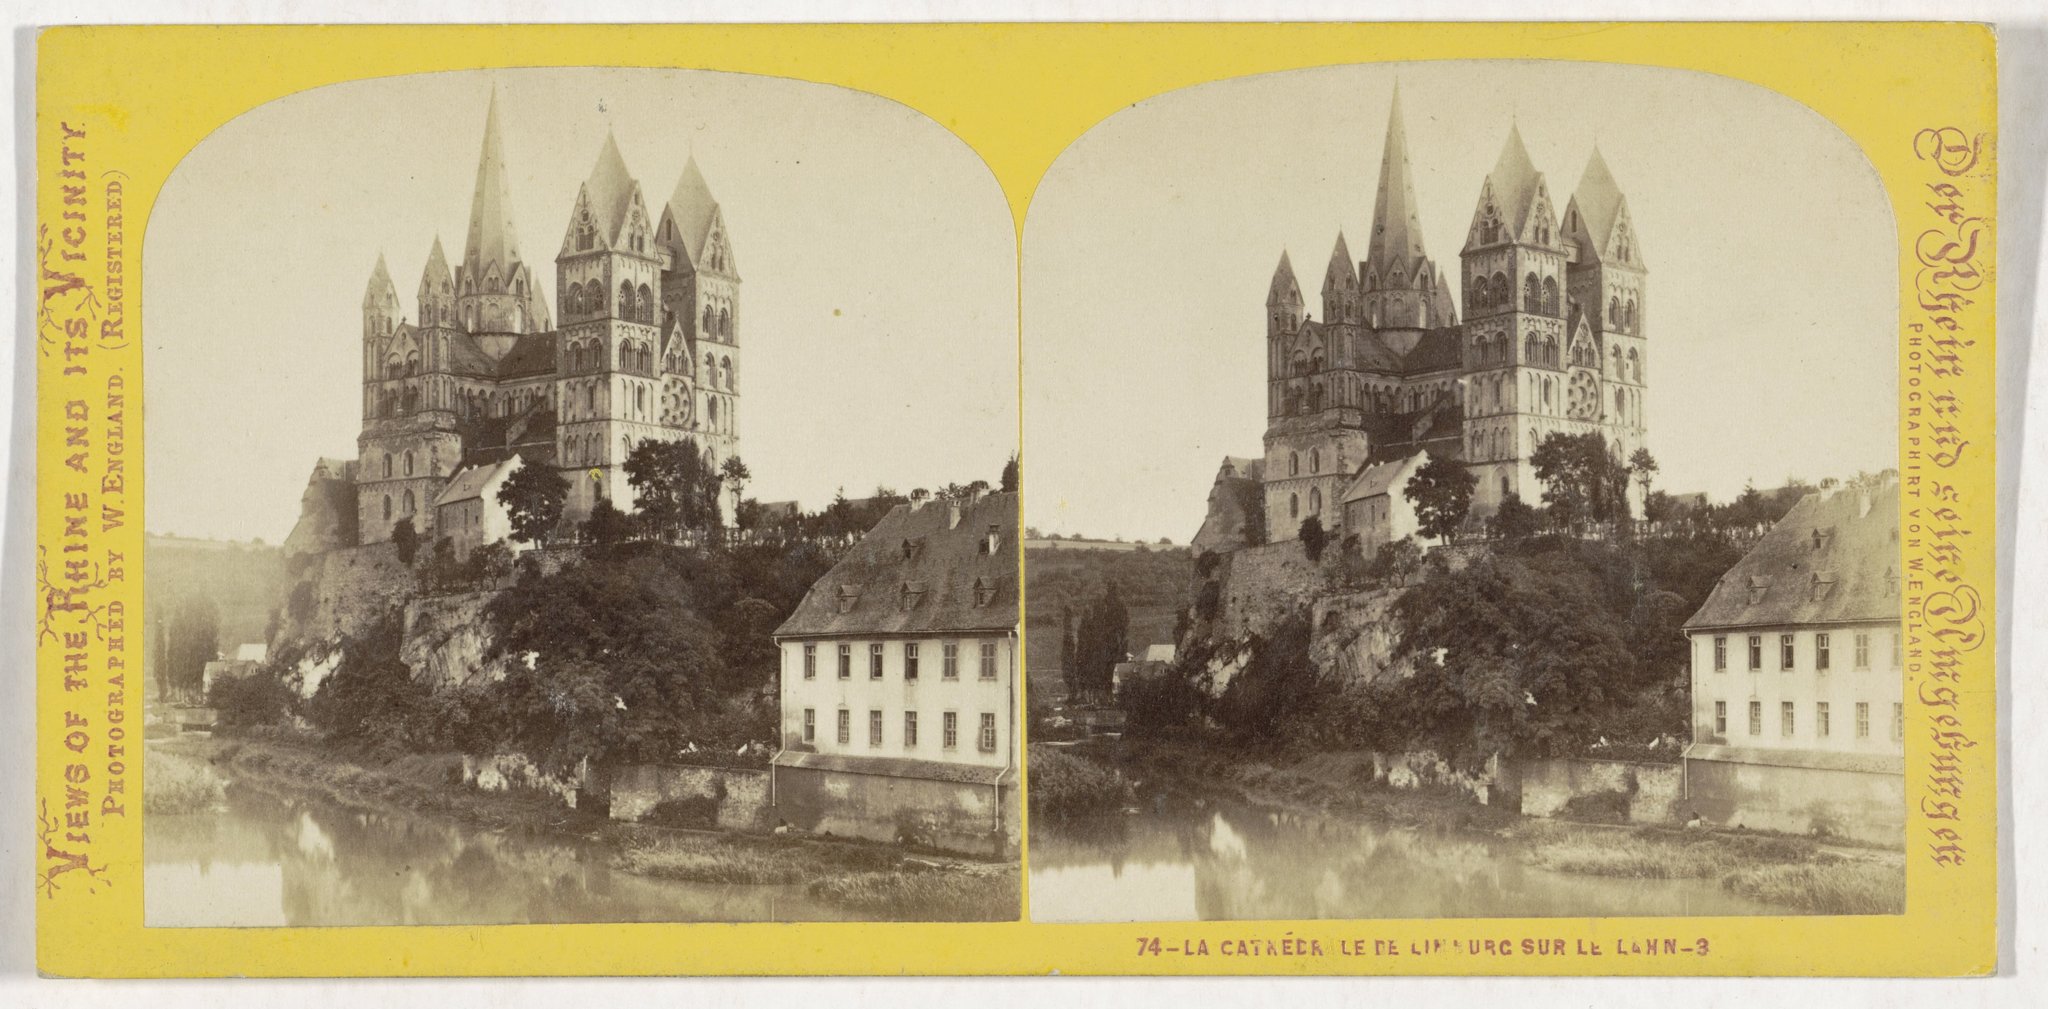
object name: stereograph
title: Dom van Limburg an der Lahn, Duitsland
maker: william england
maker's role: fotograaf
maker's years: 1816-1896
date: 1867-1868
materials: cardboard, paper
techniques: albumen print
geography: limburg an der lahn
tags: church (exterior)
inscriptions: inscription: ‘(Registered)’, number: ‘74’